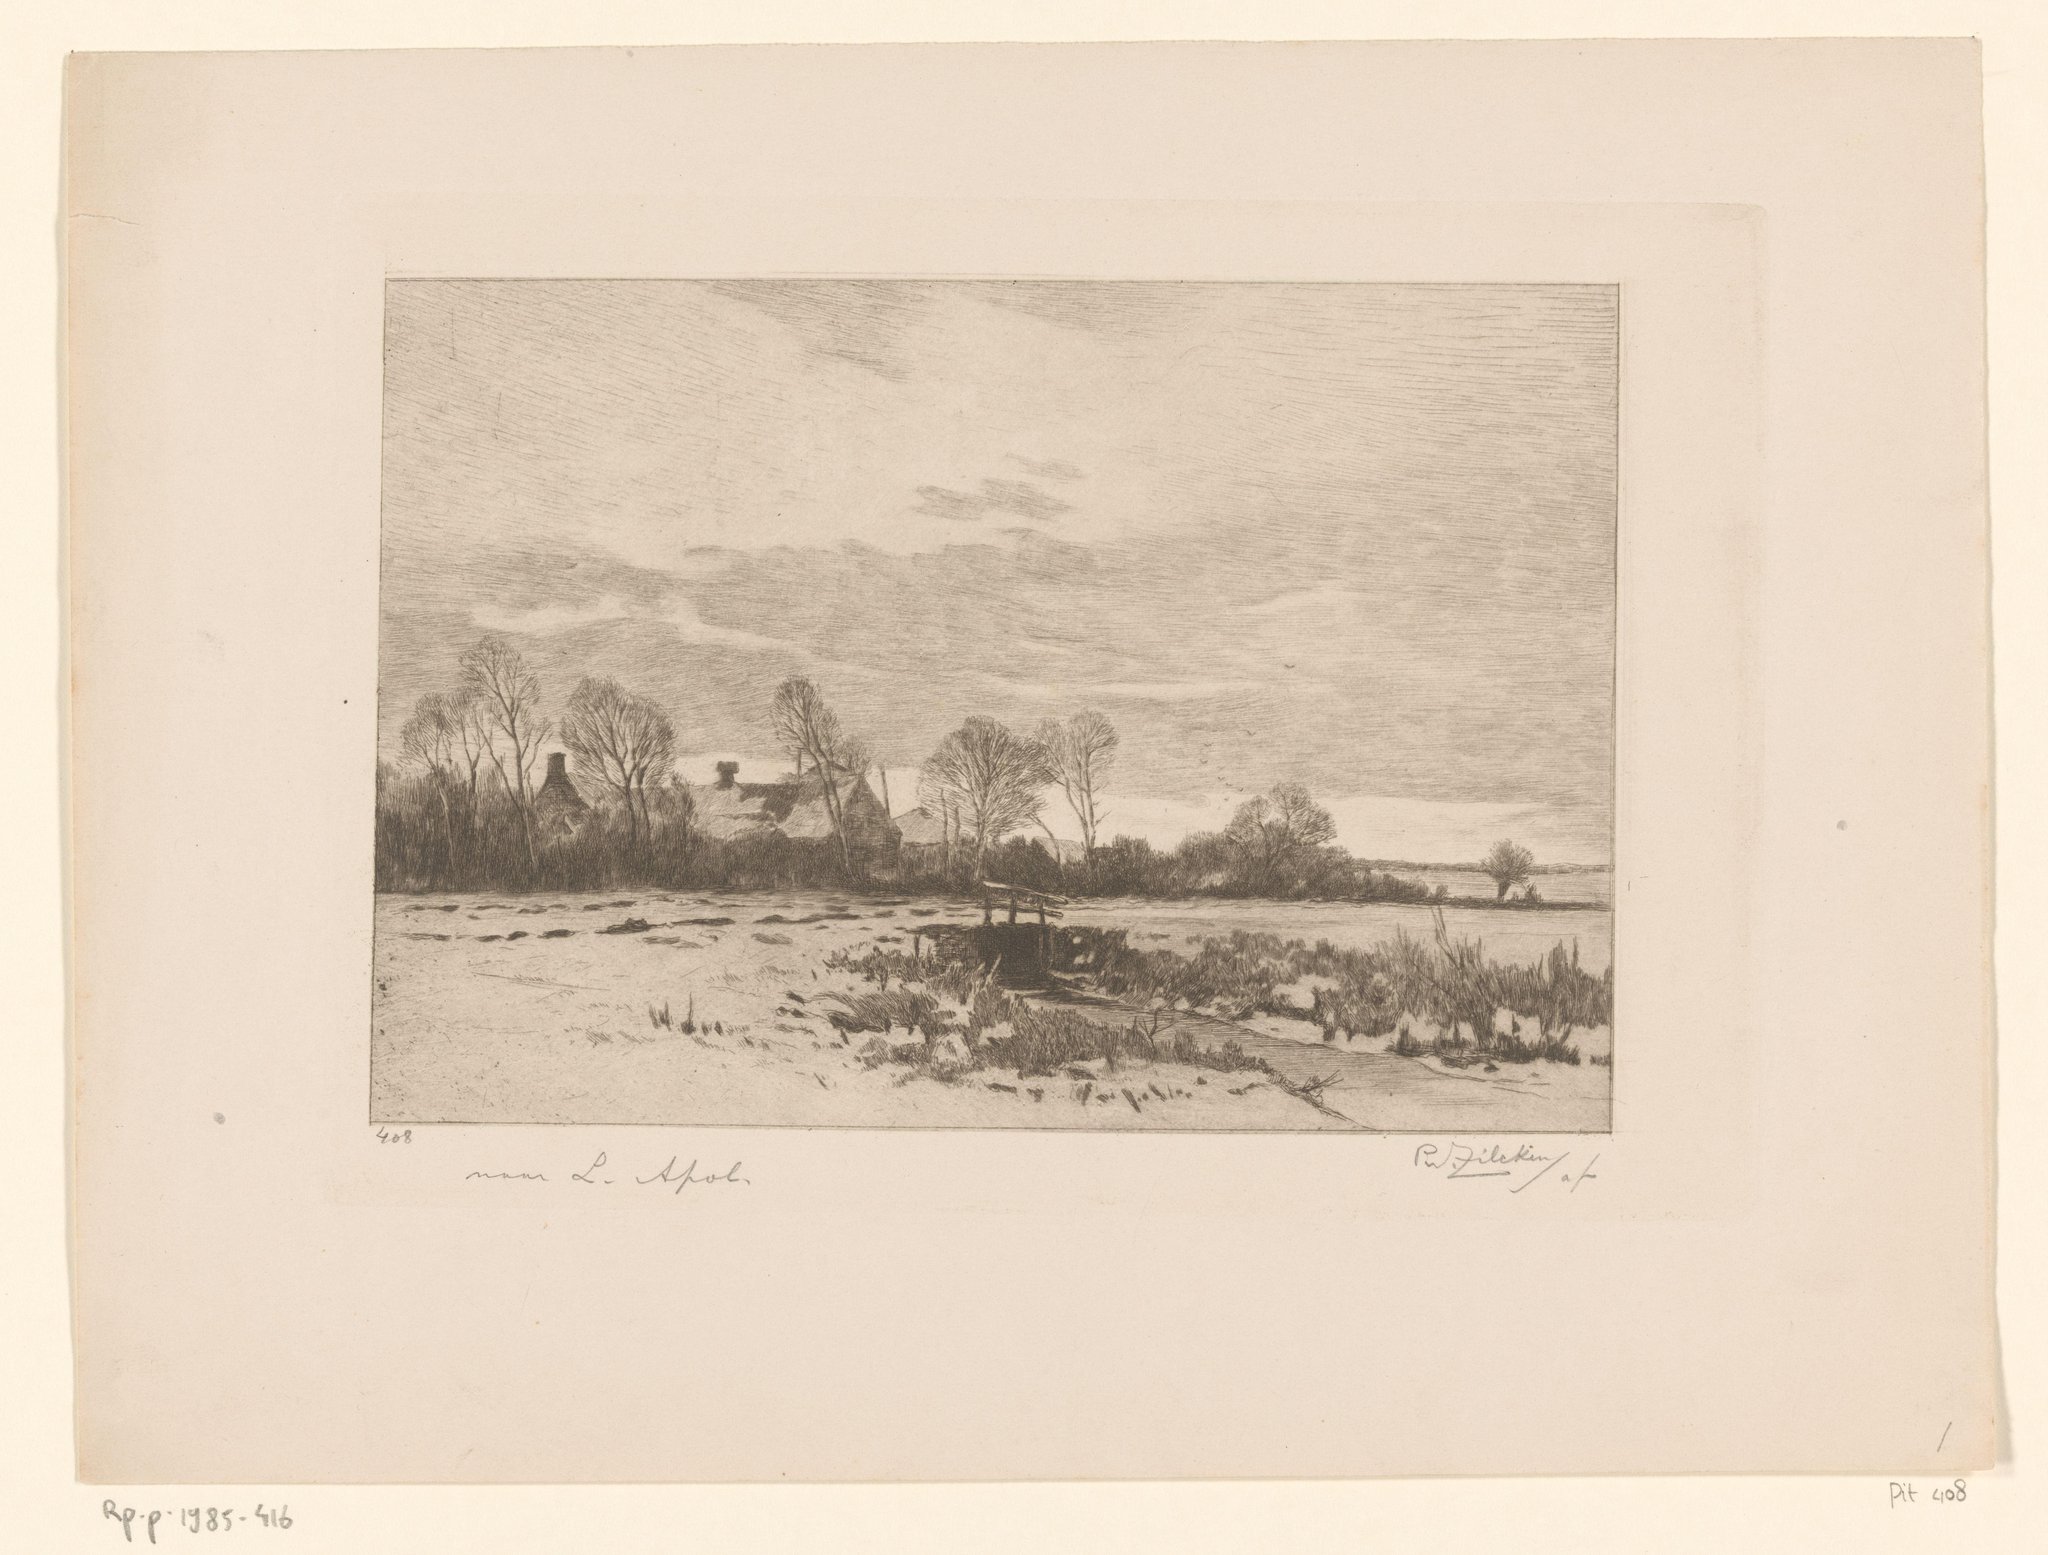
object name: print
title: Paysage d'hiver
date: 1890-1930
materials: paper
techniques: drypoint, etching, intaglio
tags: meadow, pasture, winter landscape; landscape symbolizing winter (the four seasons of the year), farm or solitary house in landscape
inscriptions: collector's mark: Lugt 2228, collector's mark: Lugt 2760